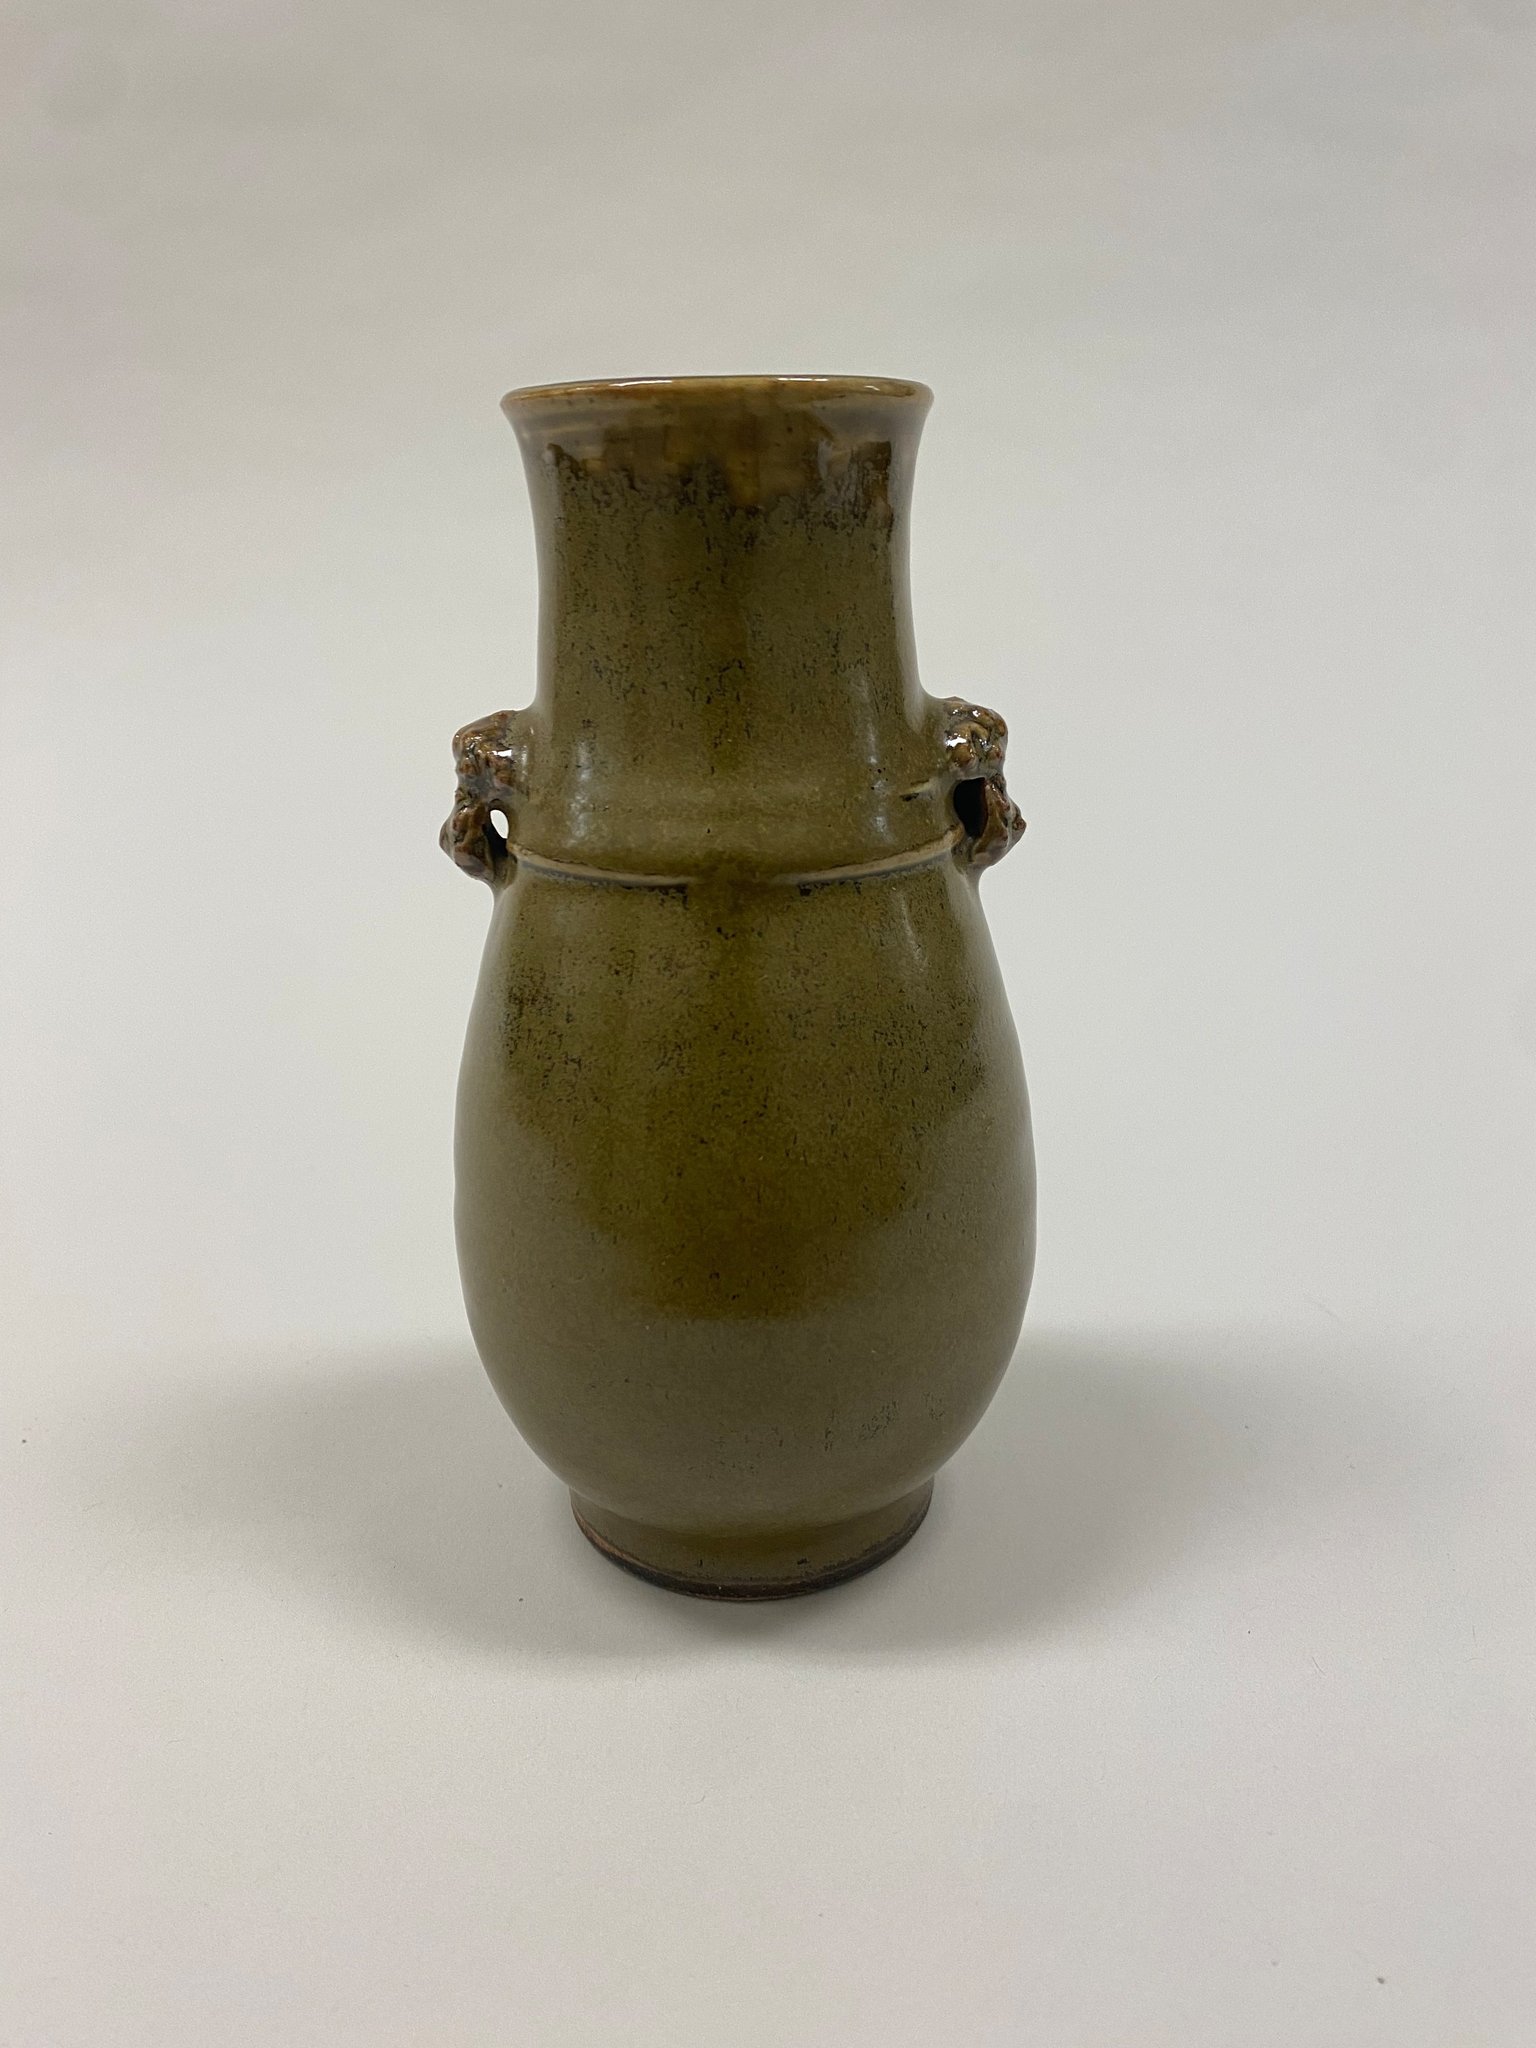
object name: vase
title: Vase with animal masks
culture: chinese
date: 1767-1800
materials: glaze, porcelain